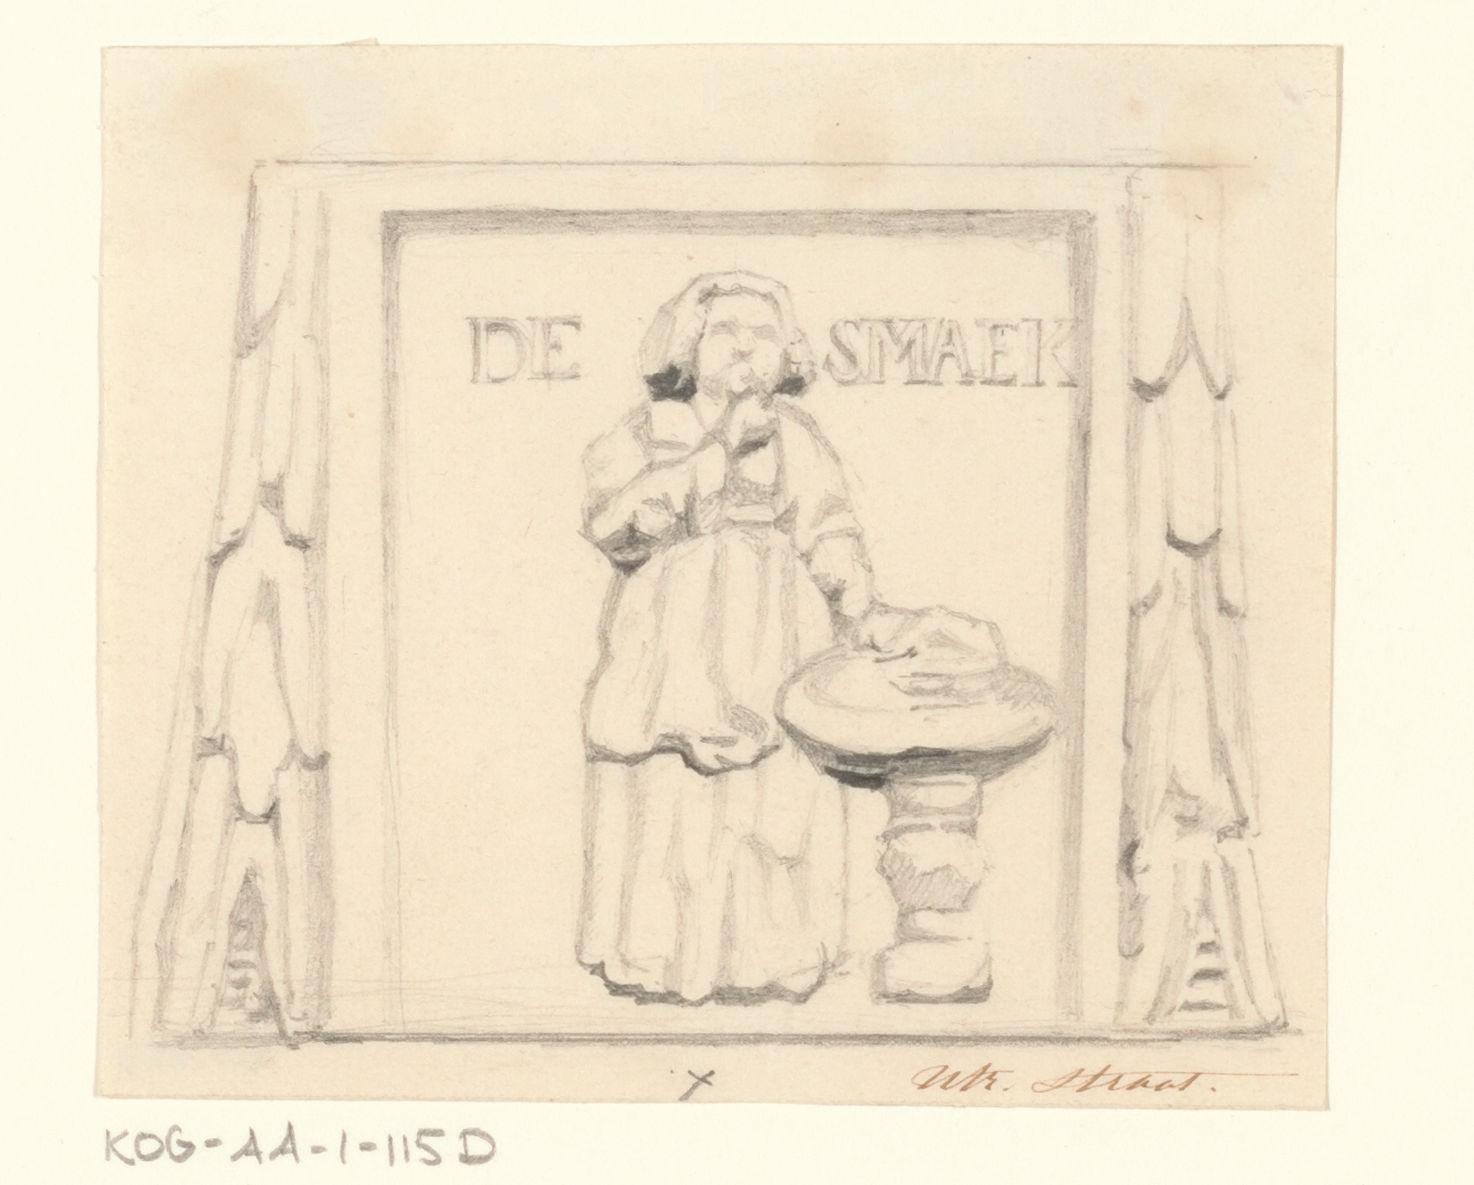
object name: drawing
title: Gevelsteen met de verbeelding van de Smaak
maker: Anonymous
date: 1800-1899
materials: paper, pencil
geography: amsterdam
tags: taste, tasting (one of the five senses), stone tablet in façade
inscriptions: inscription: ‘Utr. straat.’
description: Onderwerpsrubriek binnen de Atlas Amsterdam: Beeldhouwkunst - Gevelstenen.